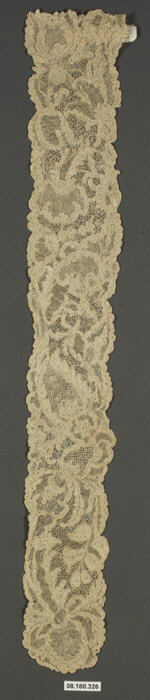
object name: barbe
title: Barbe (one end)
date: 1701-1733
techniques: lace